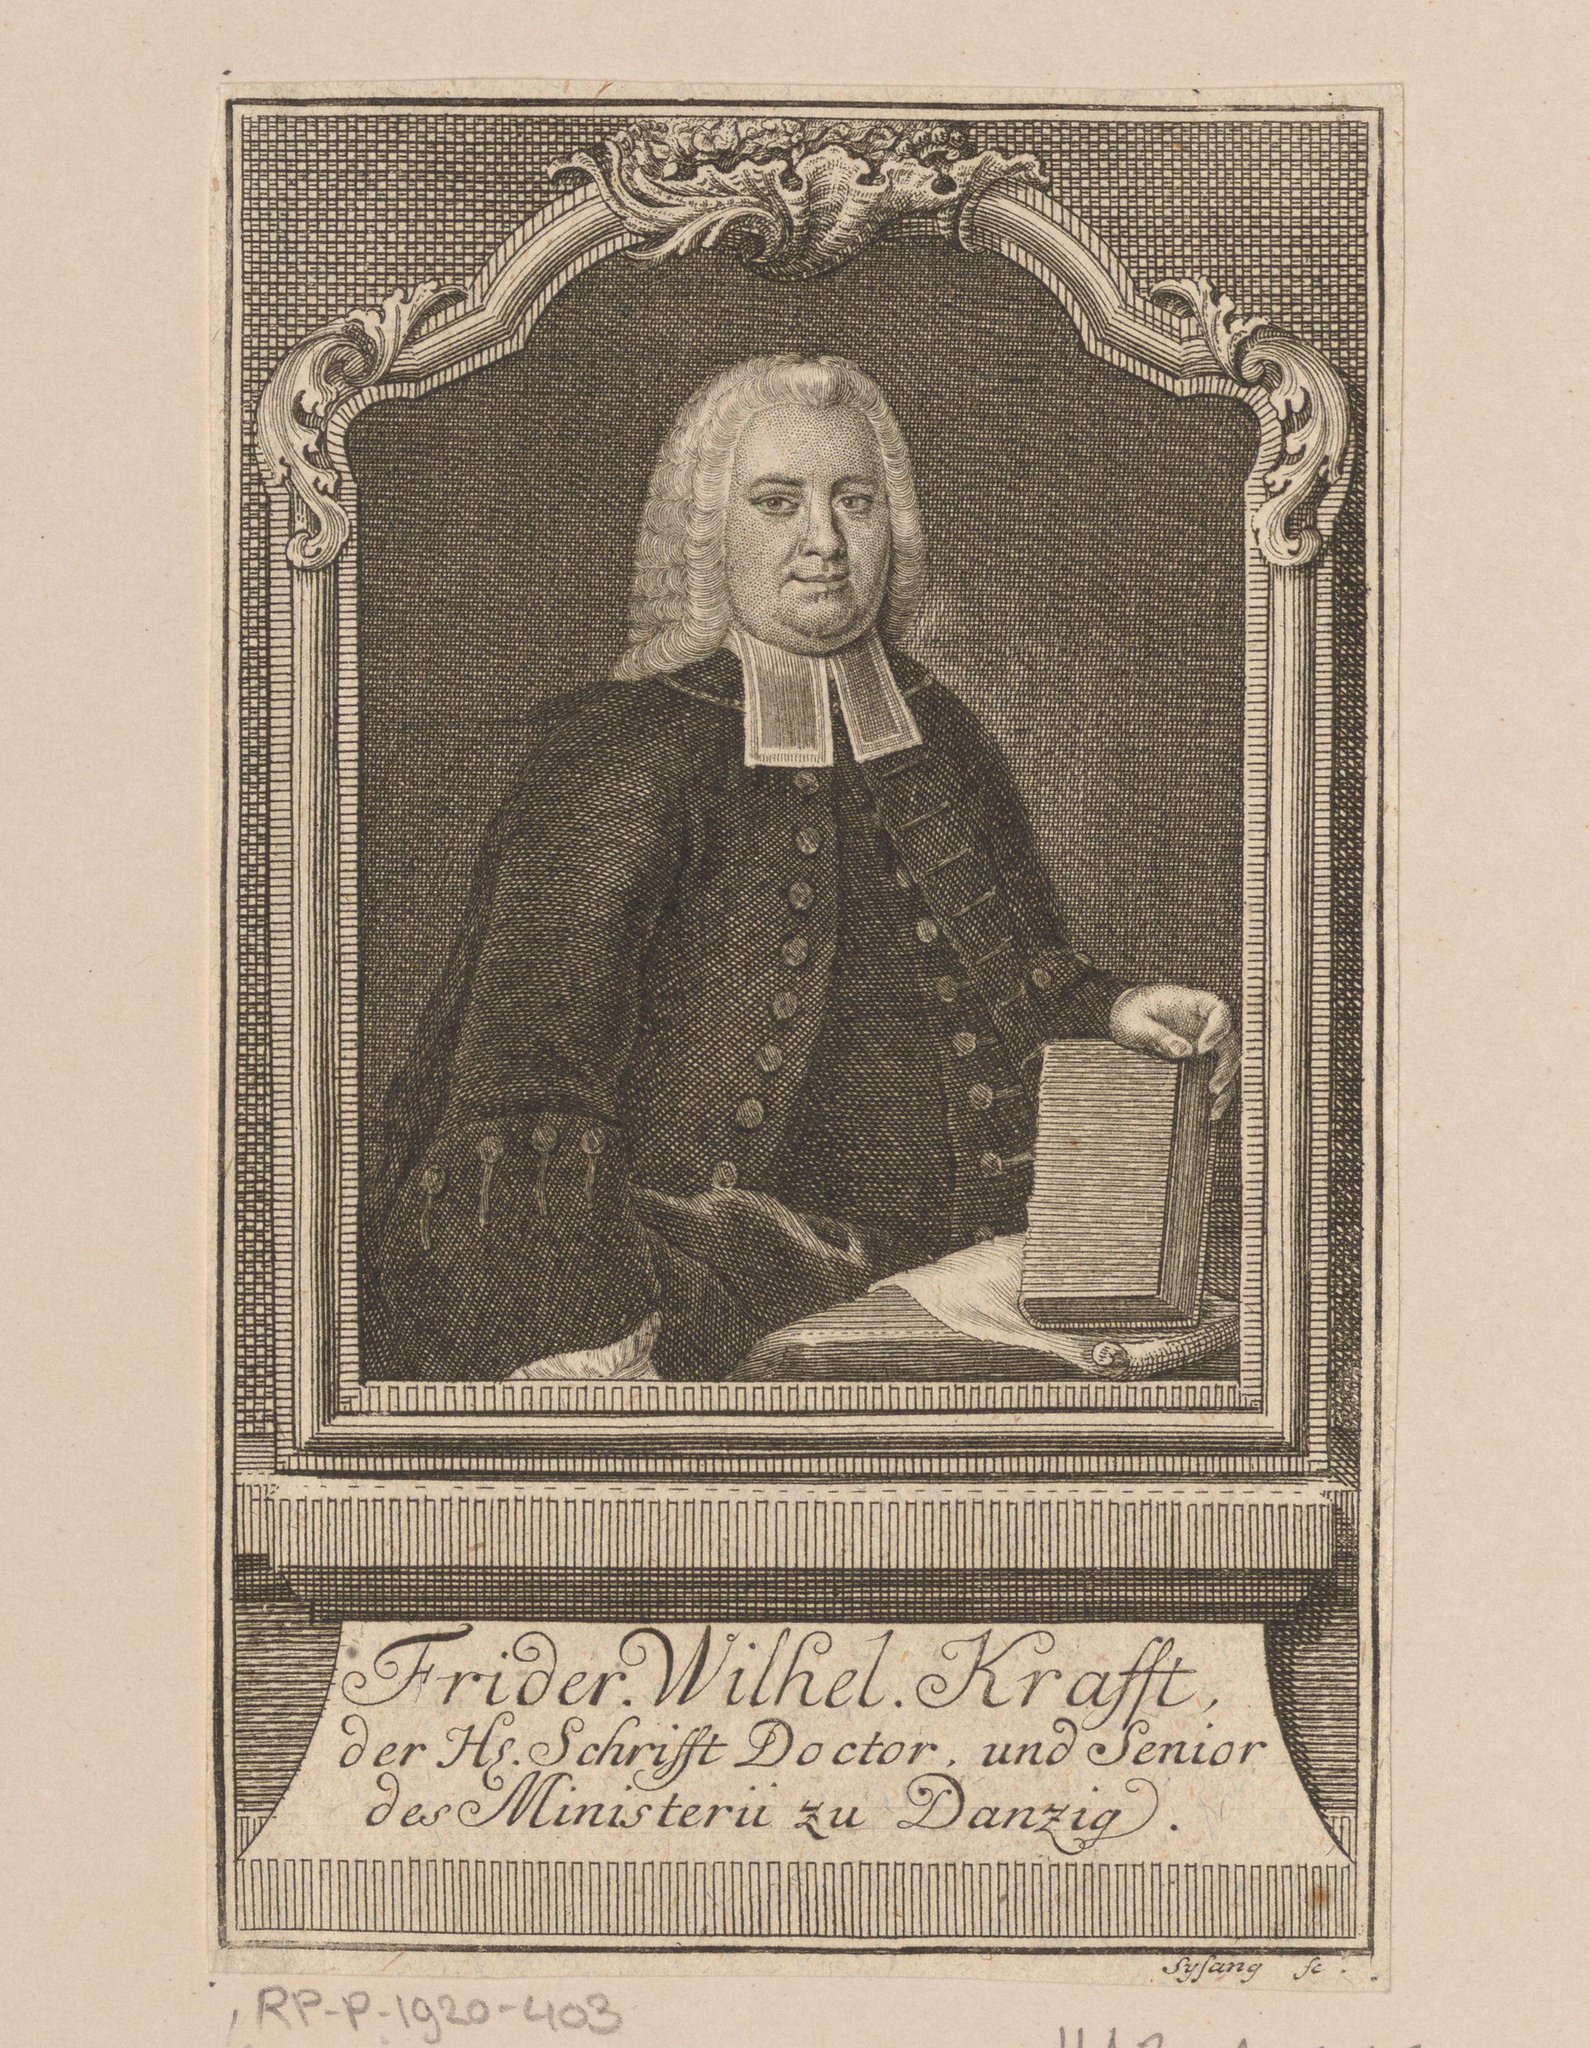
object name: print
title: Portret van Friedrich Wilhelm Kraft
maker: johann christoph sysang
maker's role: print maker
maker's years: 1703-1757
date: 1754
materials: paper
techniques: engraving, etching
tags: theologian, historical persons, book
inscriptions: collector's mark: Lugt 2228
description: Prent mogelijk uit: Zuverläßige Nachrichten von dem gegenwärtigen Zustande, Veränderung und Wachsthum der Wissenschaften. Leipzig: Johann Friedrich Gleditsch, 1754, dl. 173.